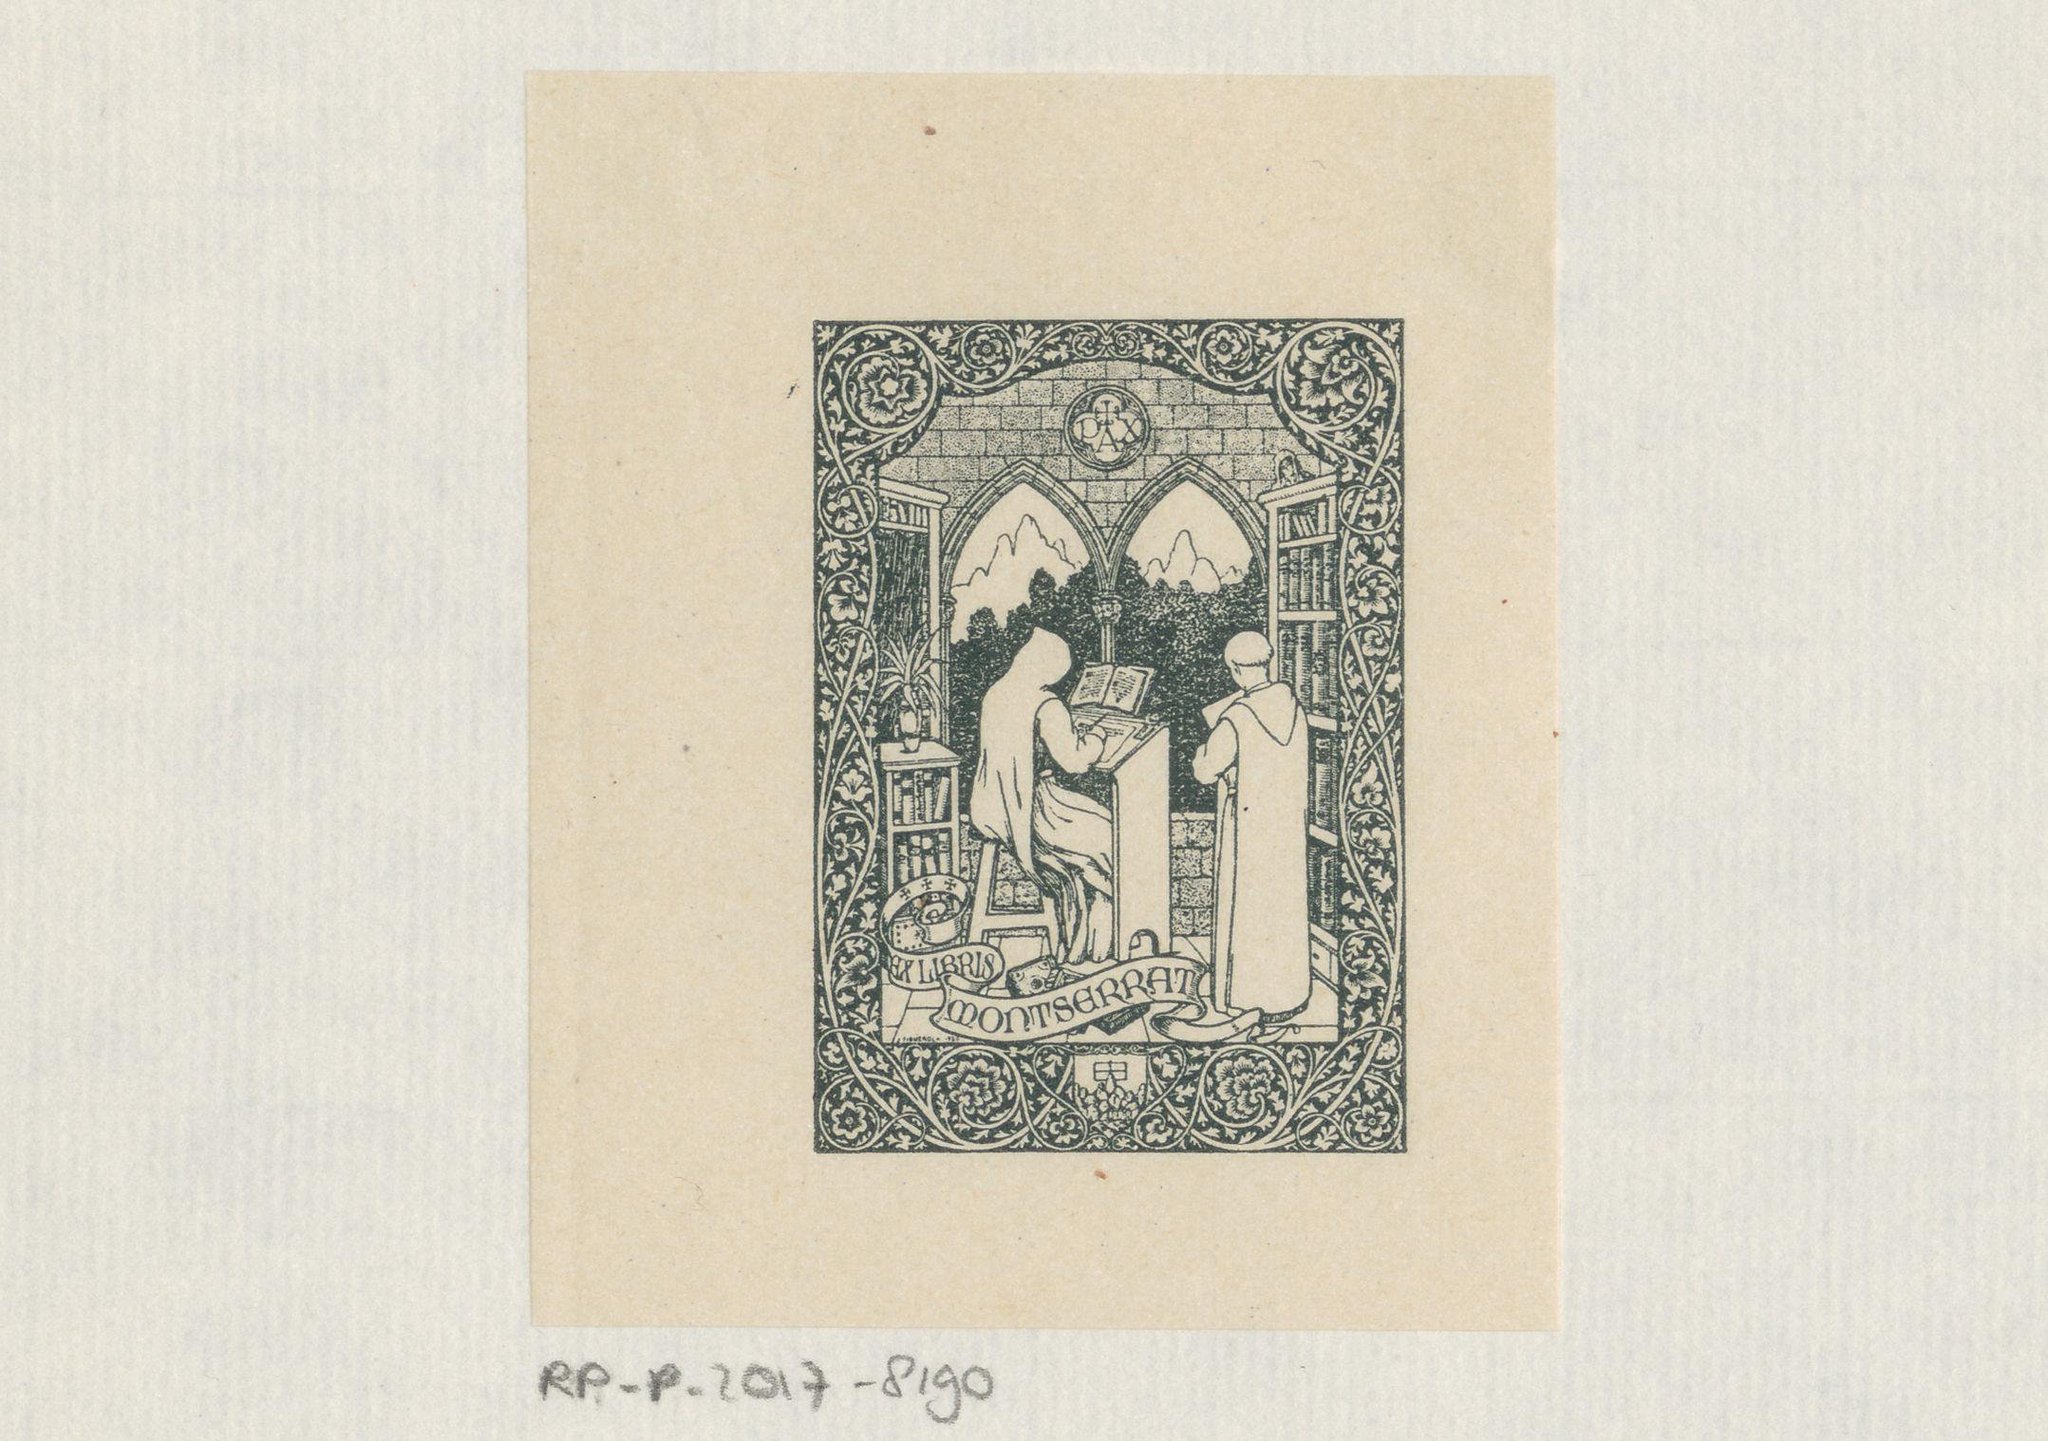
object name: bookplate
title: Ex libris Montserrat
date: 1920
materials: paper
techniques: printing block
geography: spain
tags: bookshelves, view through a window, monk(s), friar(s)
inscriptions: date